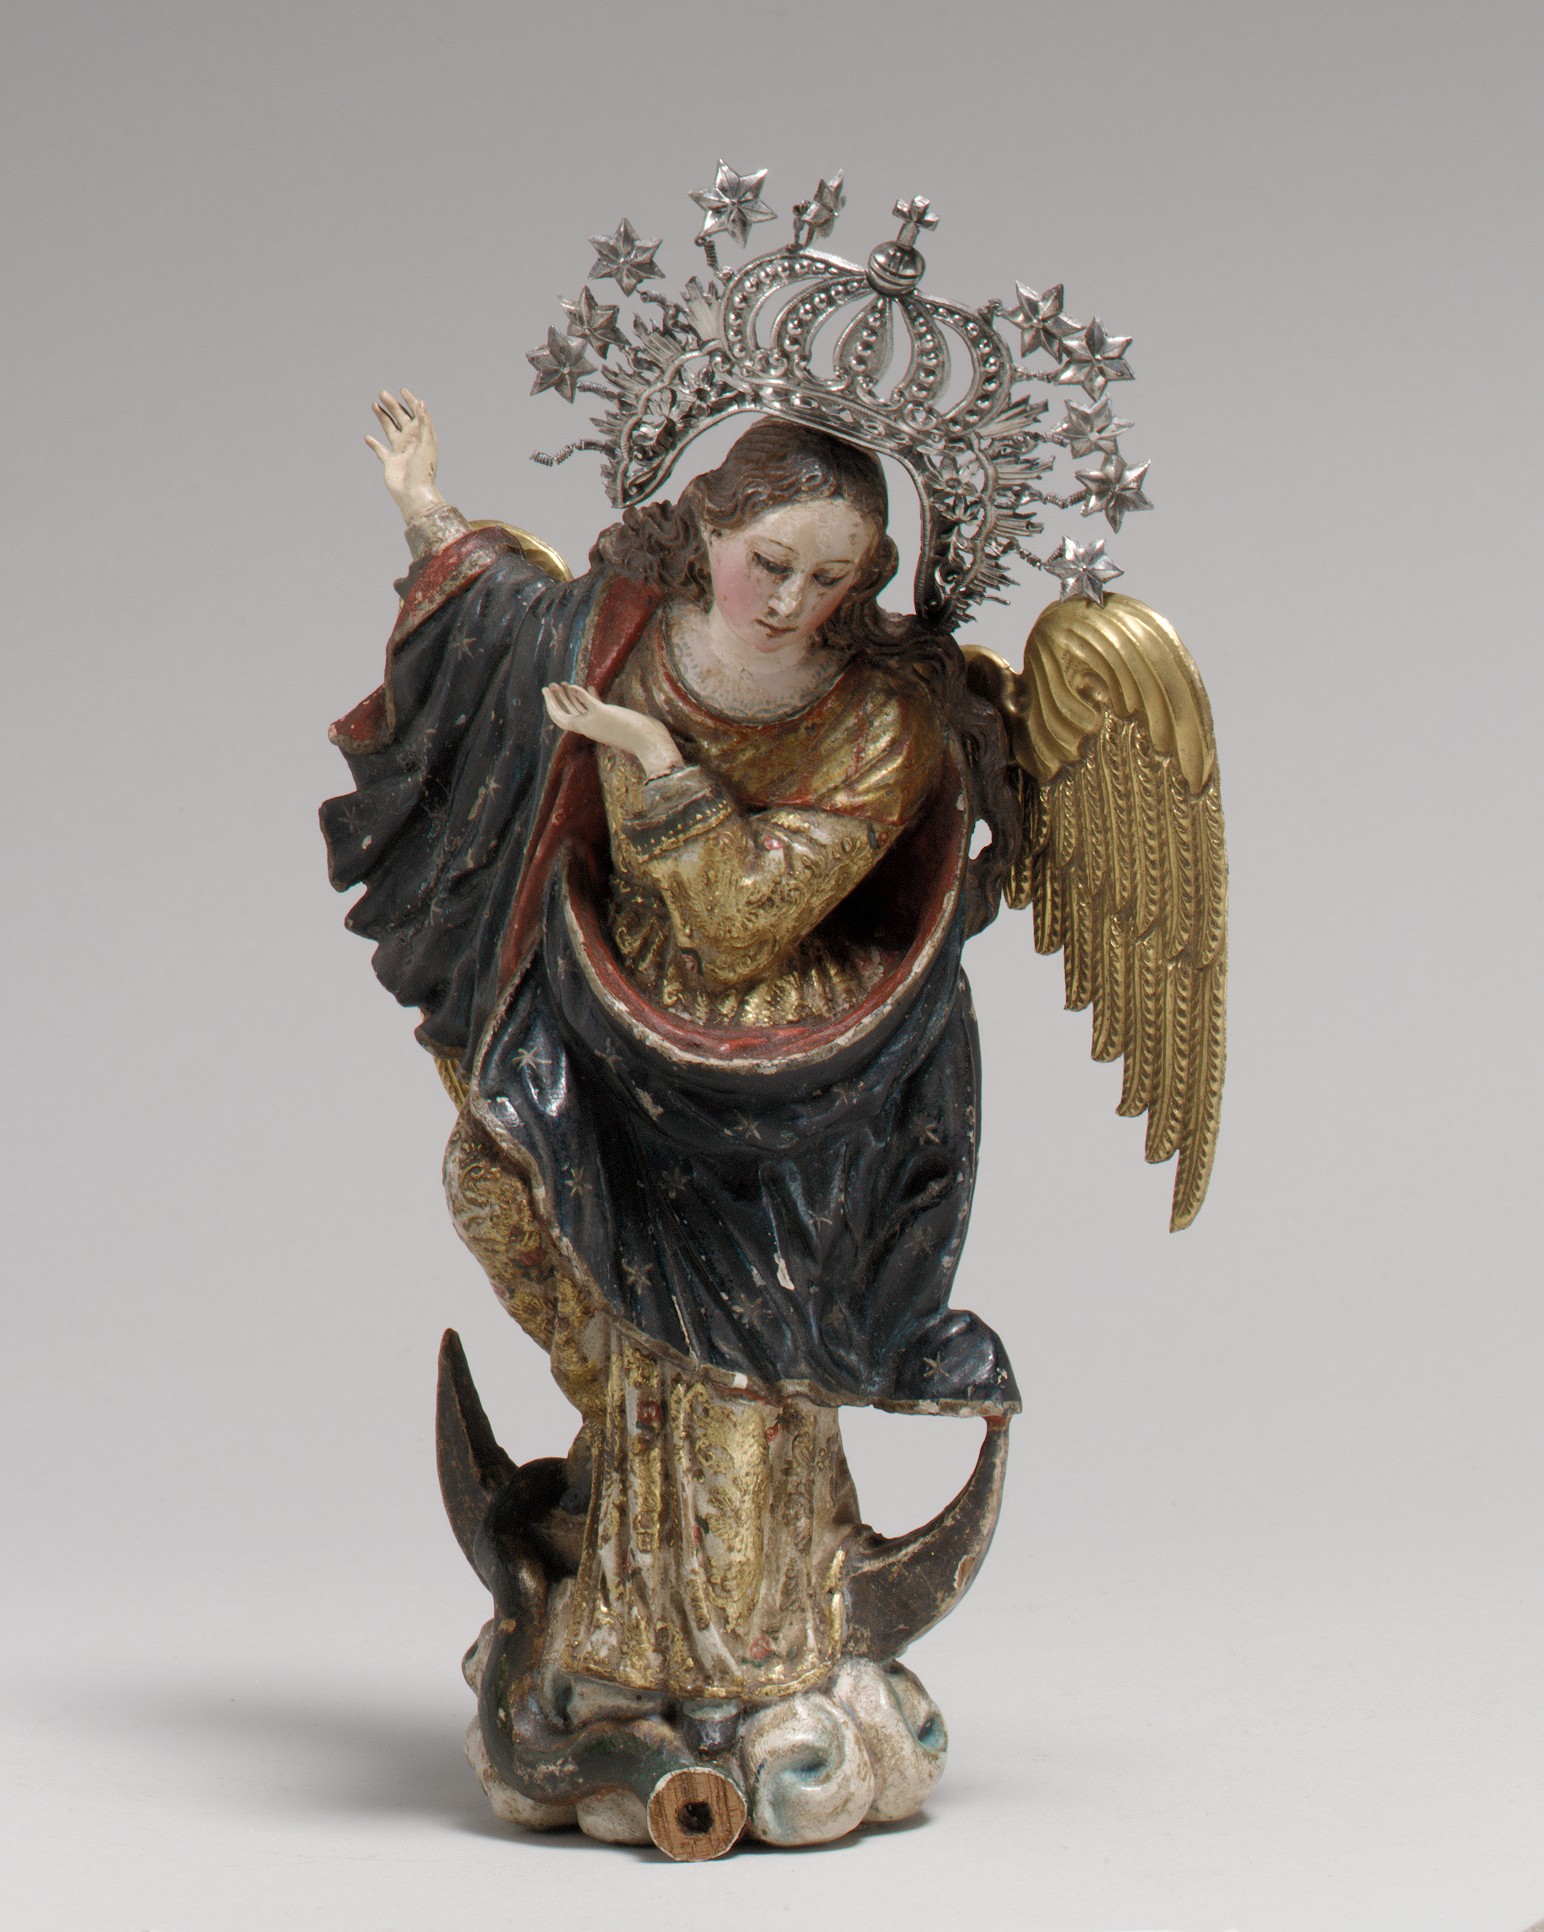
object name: statuette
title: Virgin of Quito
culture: ecuadorian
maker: bernardo legarda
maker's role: artist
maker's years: 1731-1773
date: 1701-1800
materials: glass, silver, wood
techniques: gilding, polychrome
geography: ecuador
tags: virgin mary